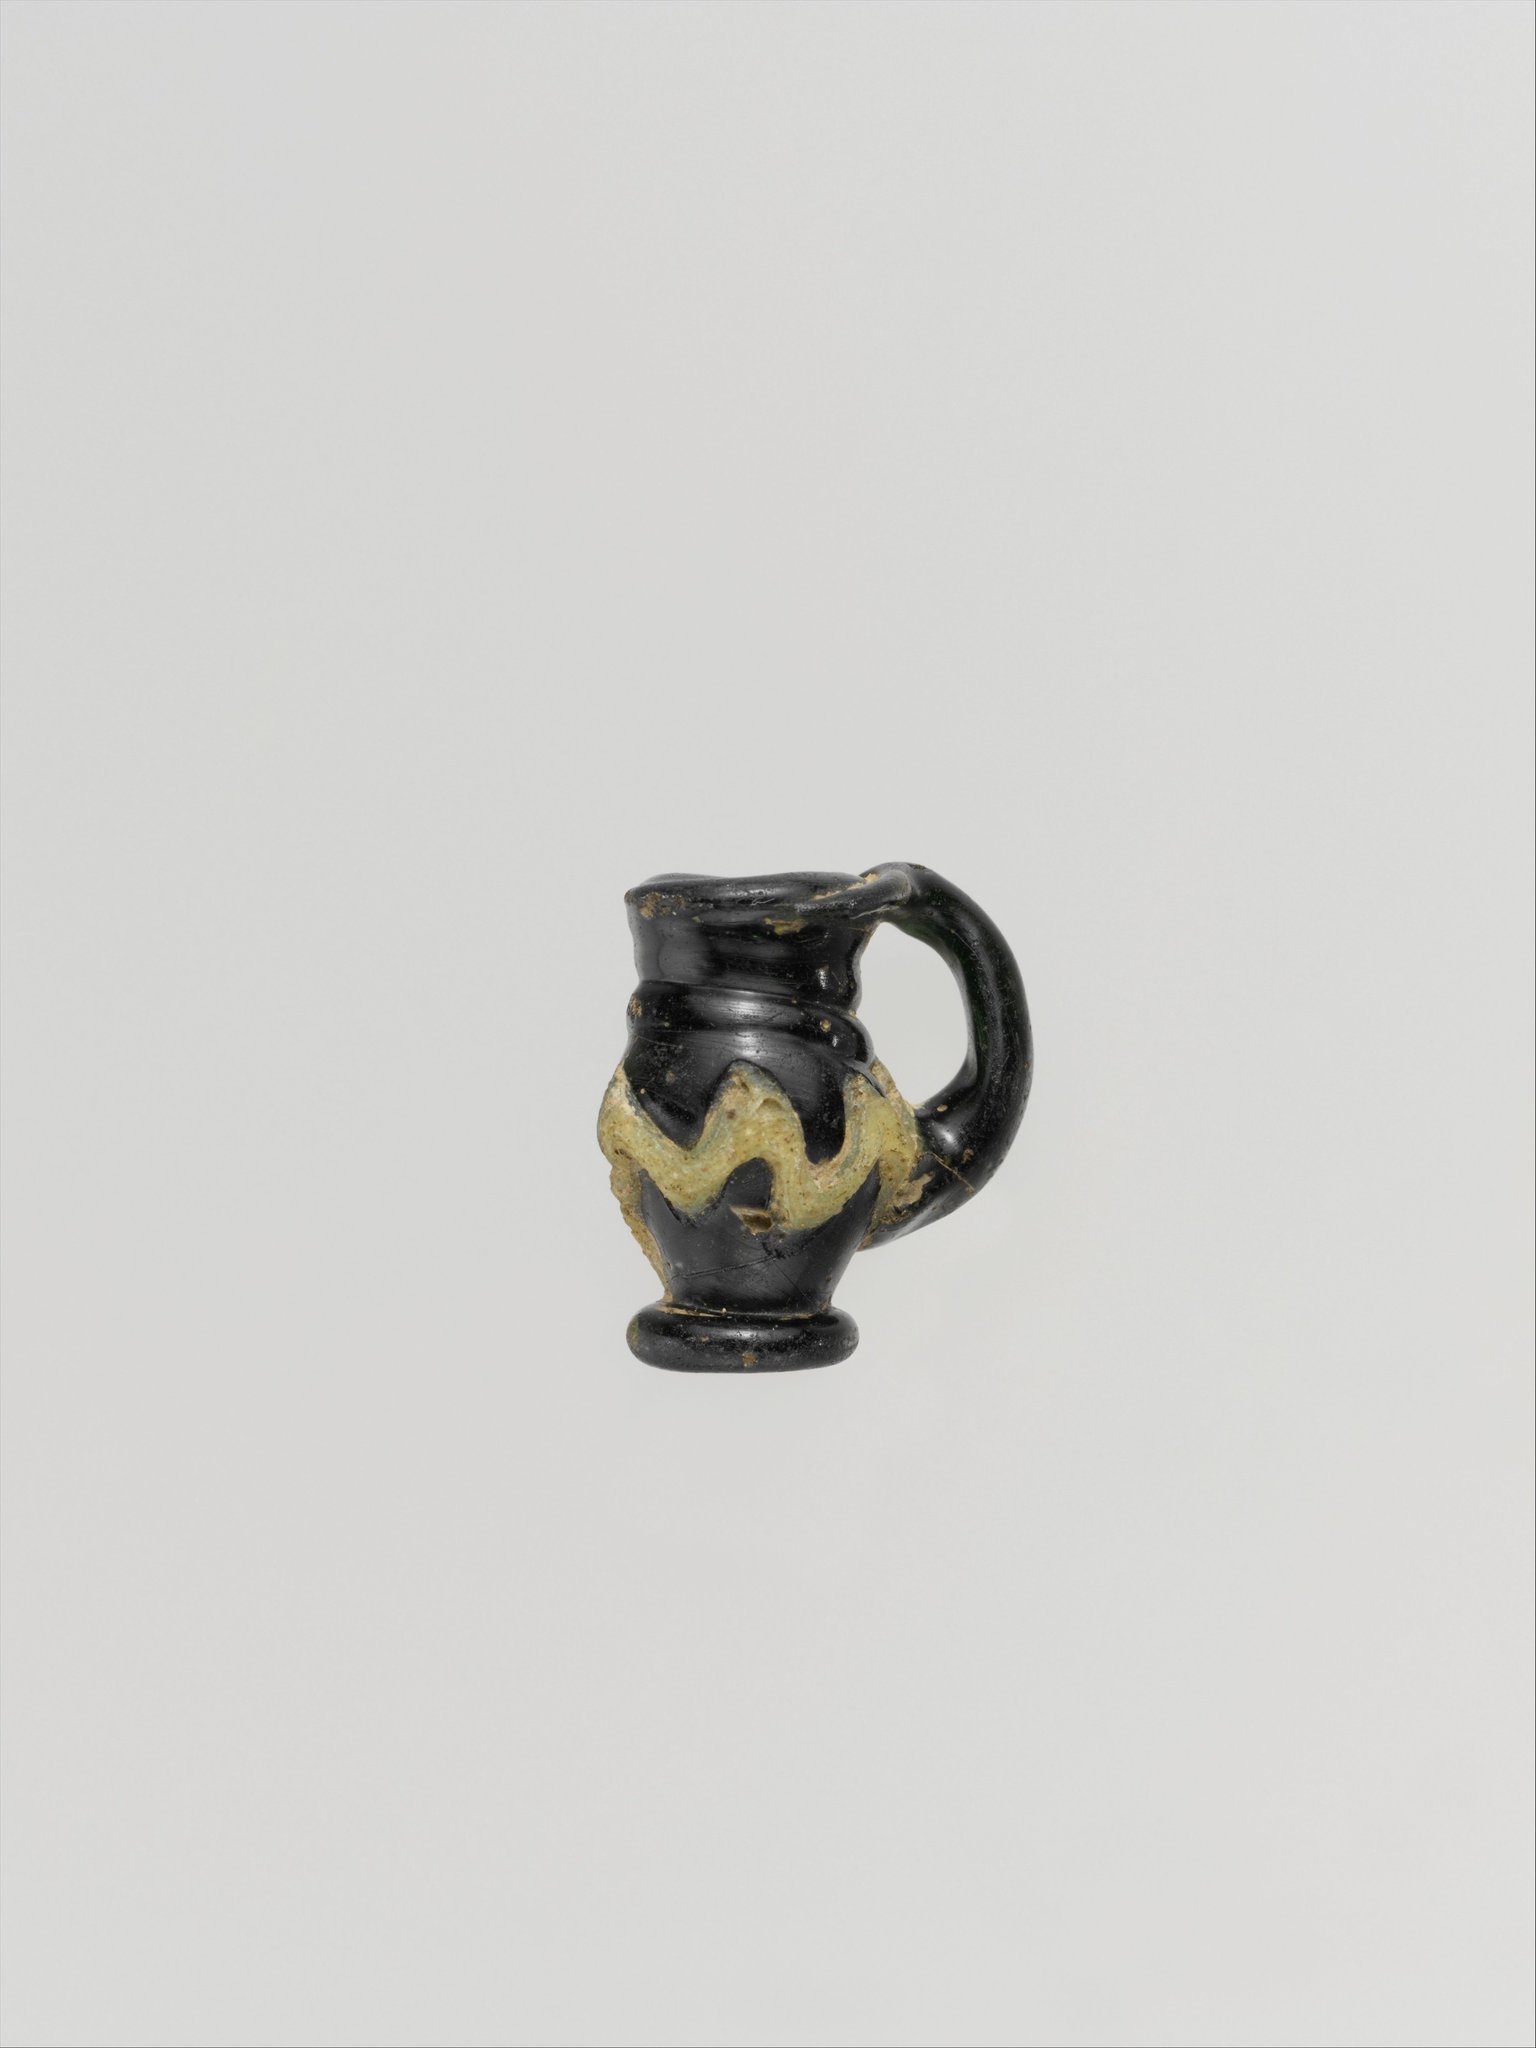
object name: pendant in the form of a miniature jug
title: Glass pendant in the form of a miniature jug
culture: roman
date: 301-400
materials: glass